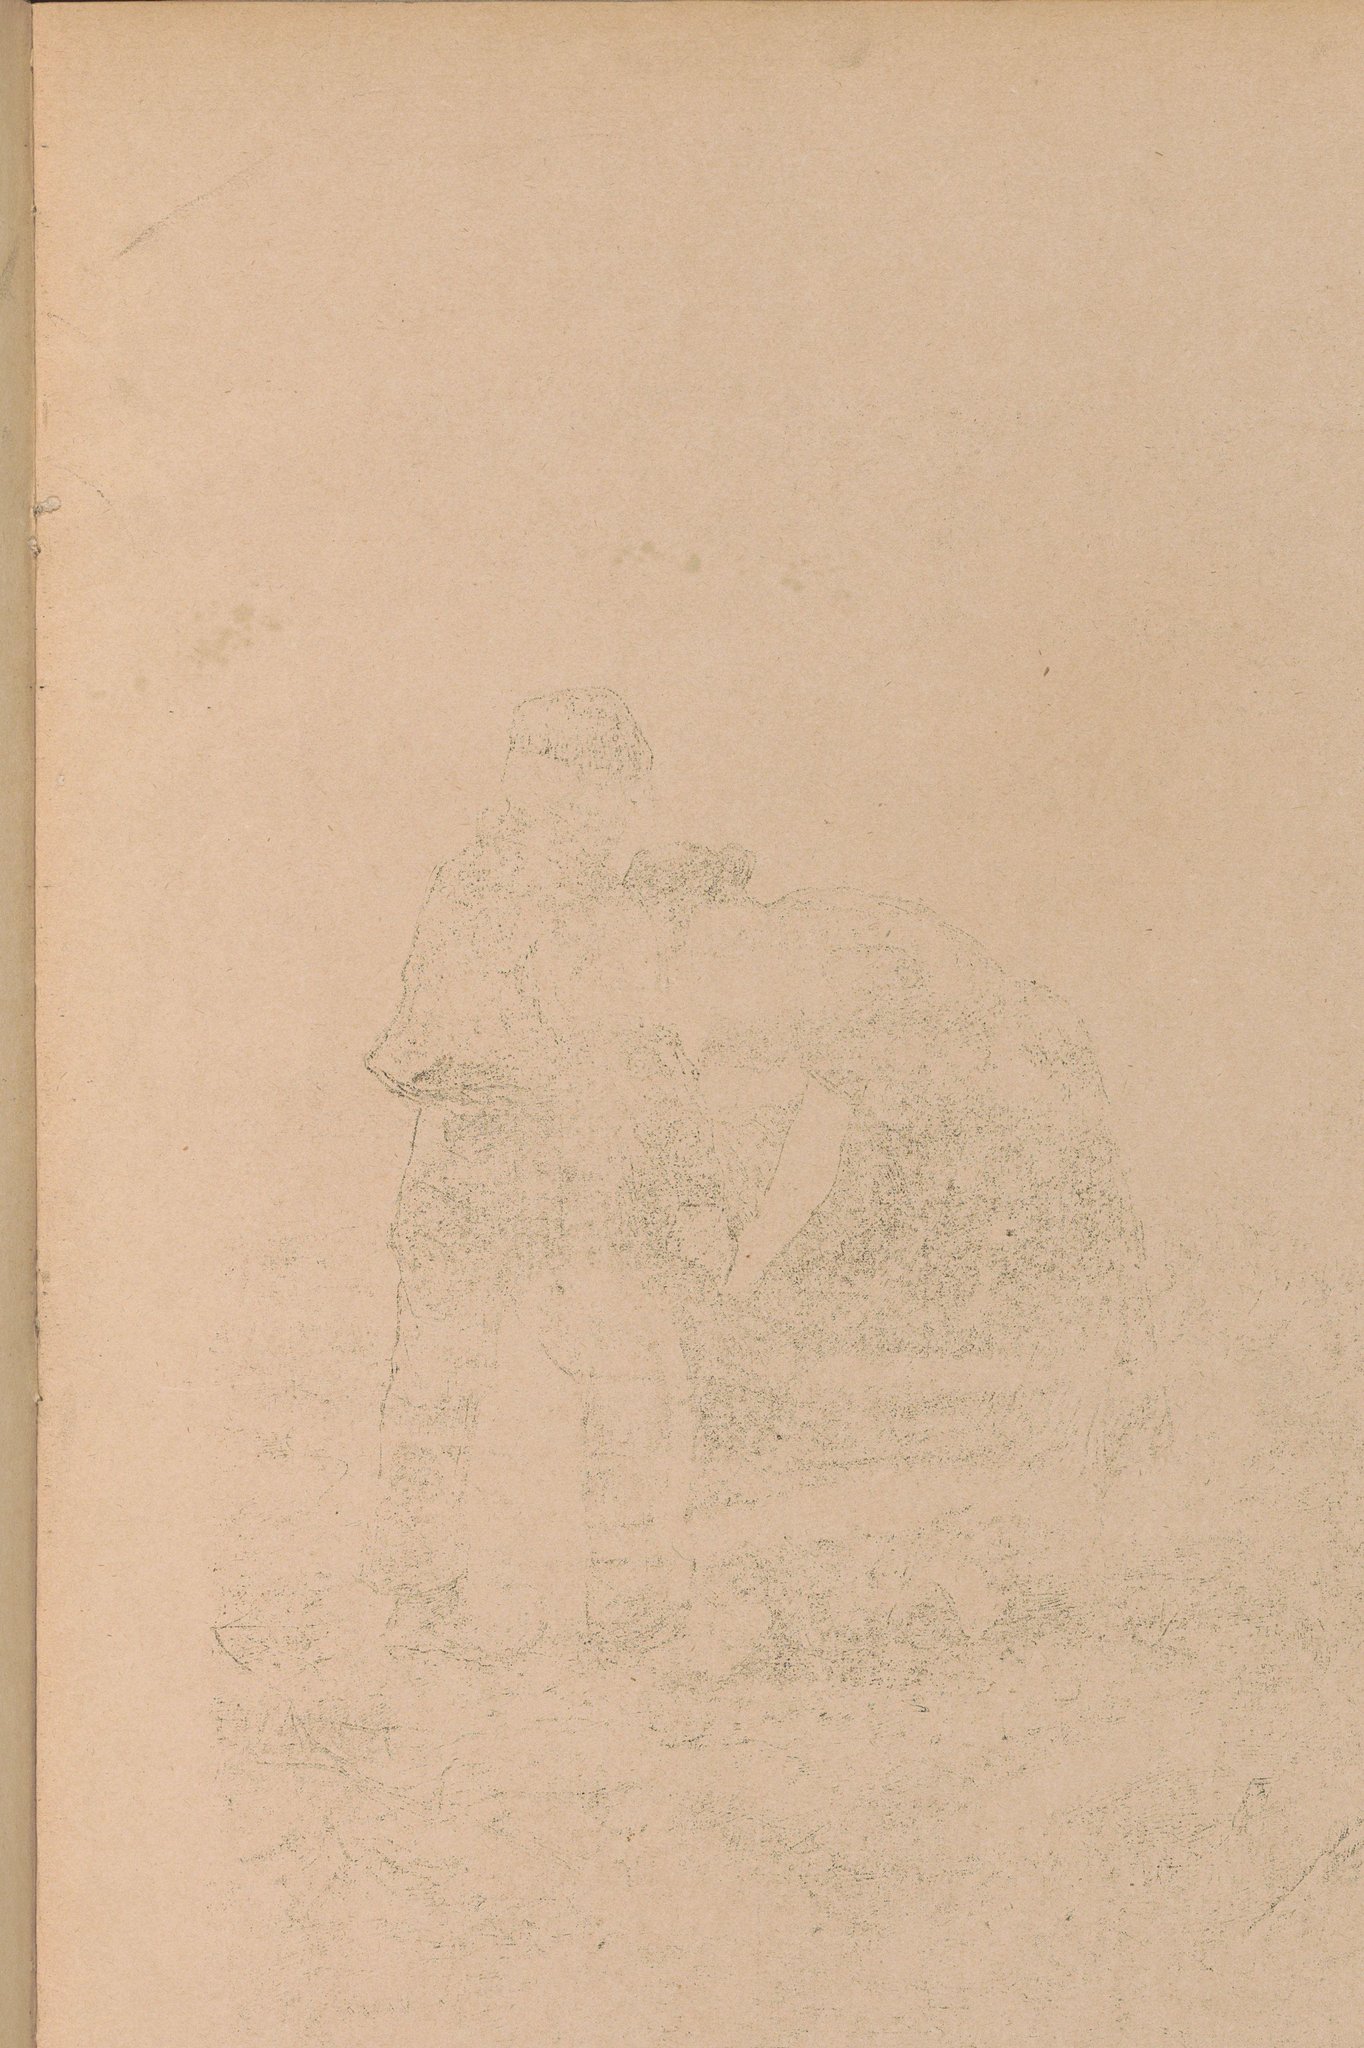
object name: sketchbook leaf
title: Abklatsch van een krijttekening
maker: willem witsen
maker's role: draughtsman, painter, print maker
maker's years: 1860-1923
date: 1884-1887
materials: paper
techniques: printmaking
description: De tekening van twee figuren die op het land werken is niet meer aanwezig. Pagina 71 uit een schetsboek met 44 bladen.